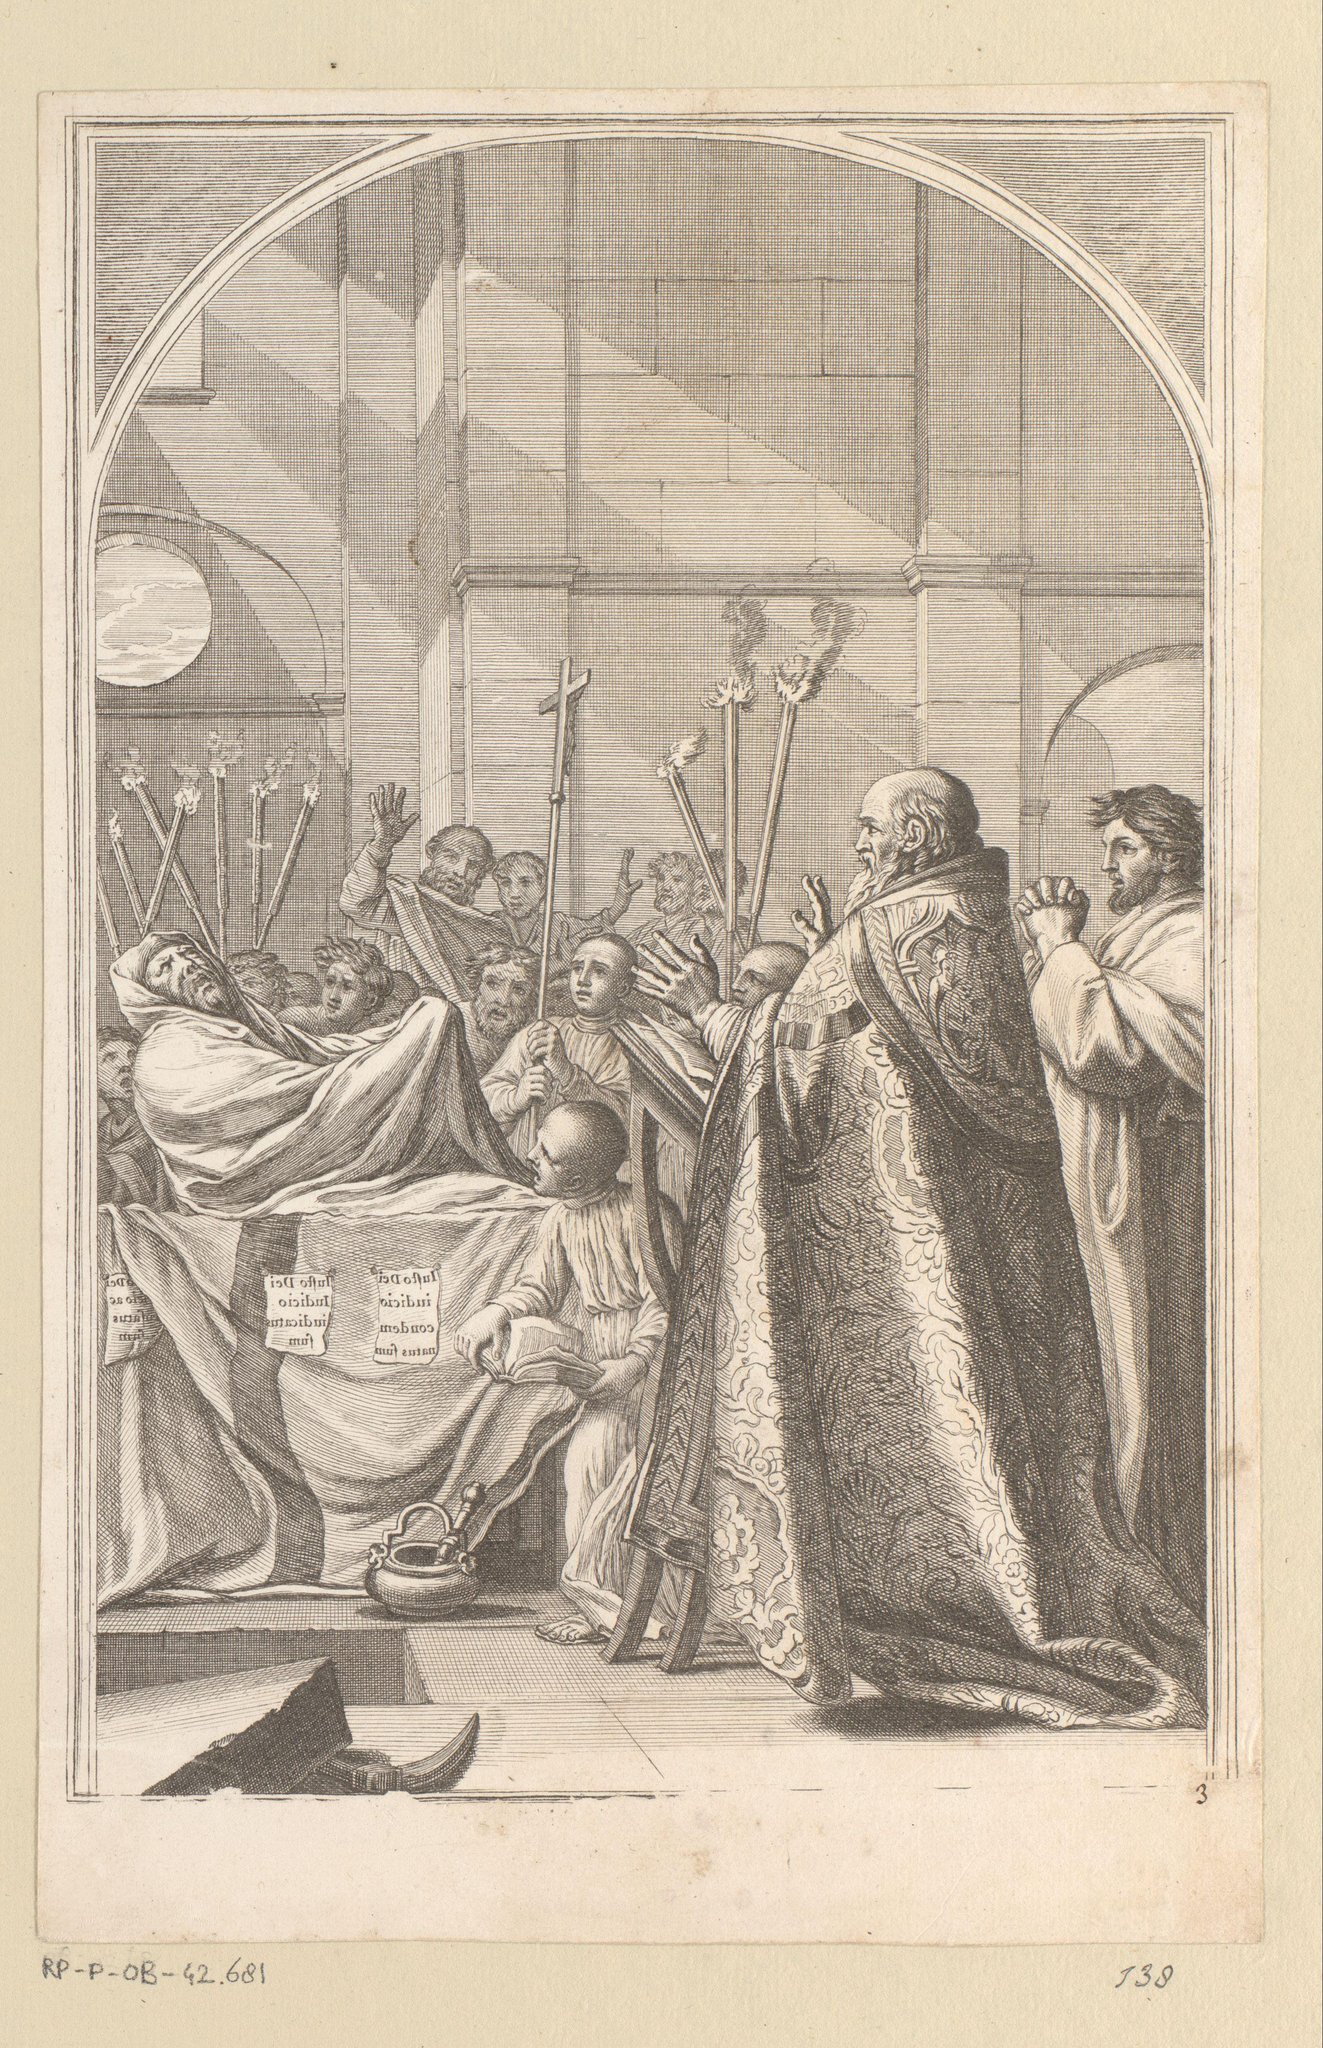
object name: print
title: La vie de St. Bruno (...)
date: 1623-1676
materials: paper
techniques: printmaking, engraving, etching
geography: france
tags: the founder of the order of the carthusians, bruno; possible attributes: cross, finger at lips, lily, mitre at his feet, olive-branch, ray of light, skull, (seven) star(s), the death of raymond diocrès: on his deathbed the tutor of st. bruno sees his own condemnation; young bruno is converted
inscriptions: collector's mark: Lugt 2165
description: Maakt deel uit van een serie met 24 prenten (inclusief twee titelprenten), naar schilderijen door Lesueur vervaardigd tussen 1645-1648 voor de Chartreuse de Paris. De serie is getiteld: La vie de St. Bruno fondateur de l'Ordre des Chartreux peinte au cloistre de la Chartreuse de Paris par Eustache Le Sueur.